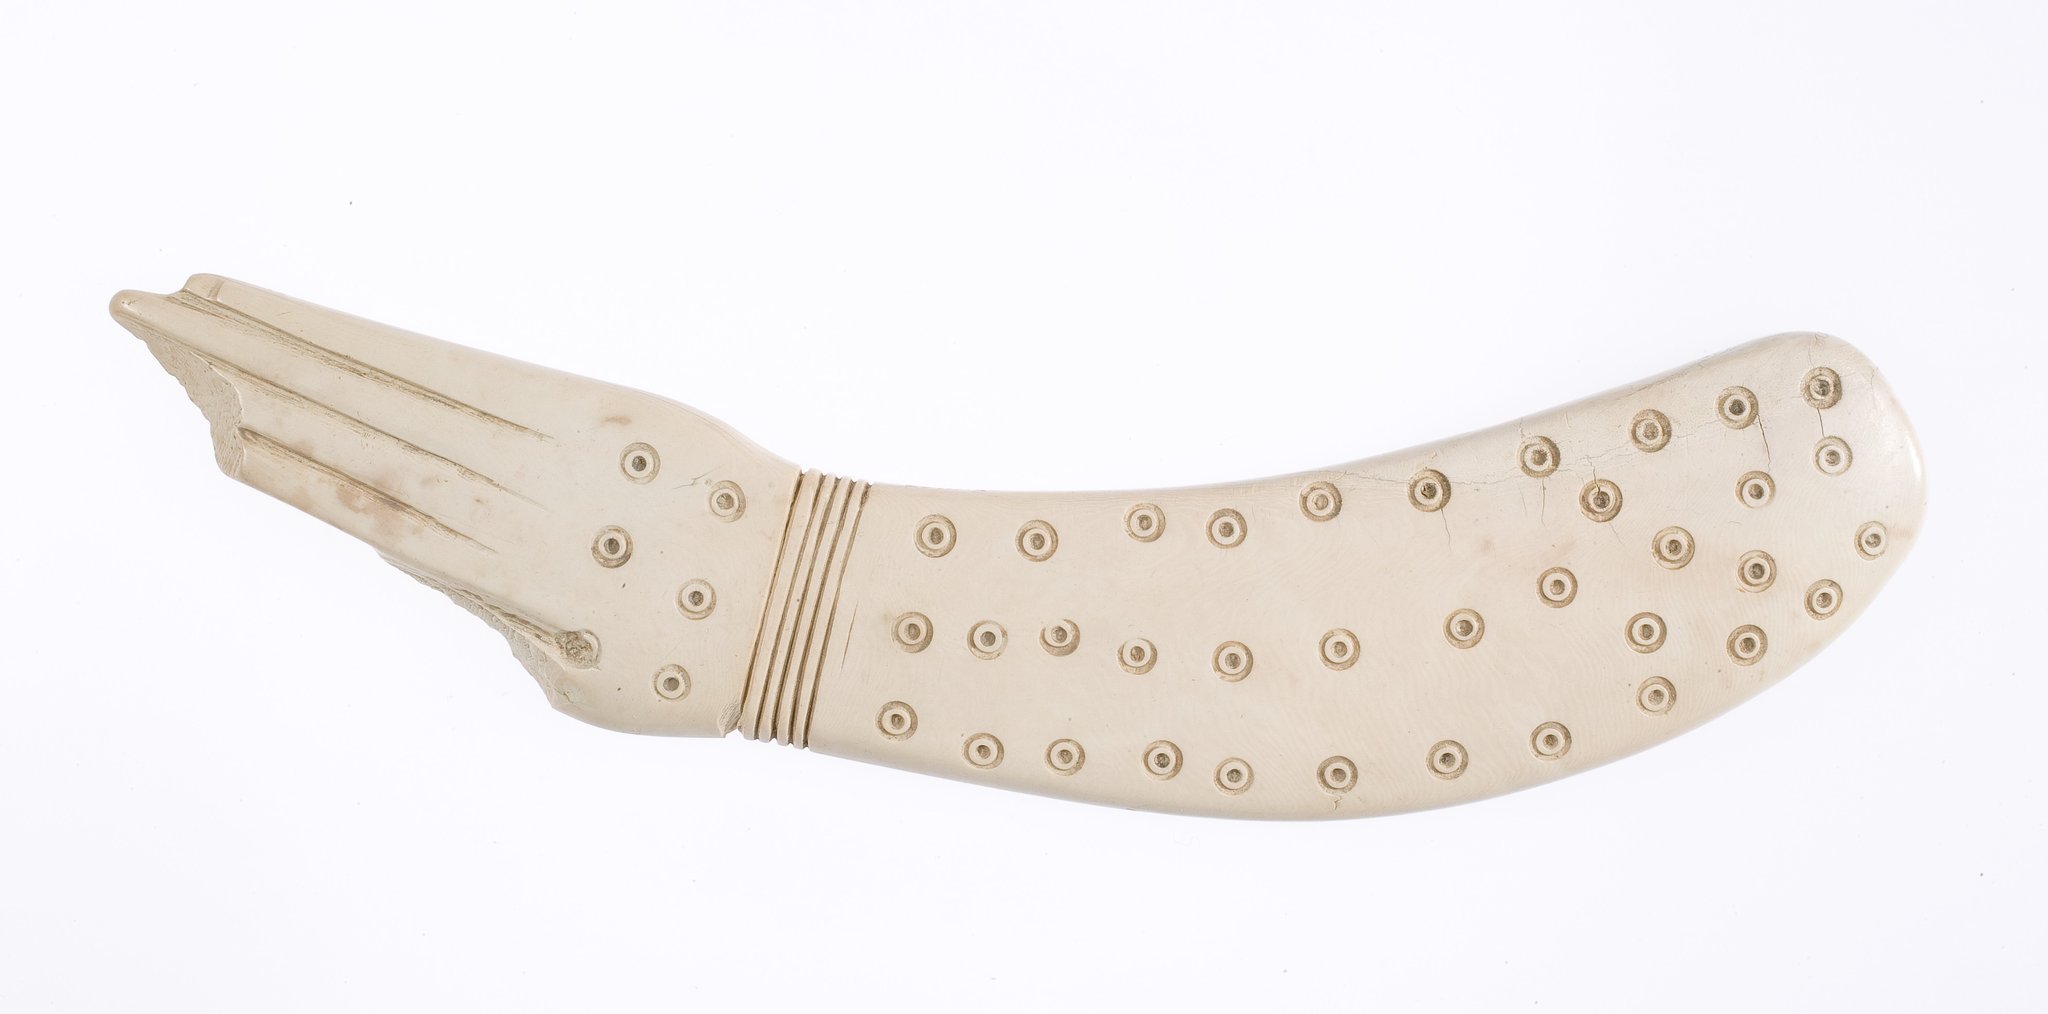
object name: music, clapper, arm, hand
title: Clapper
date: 1900-1640 BCE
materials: ivory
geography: egypt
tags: musical instruments